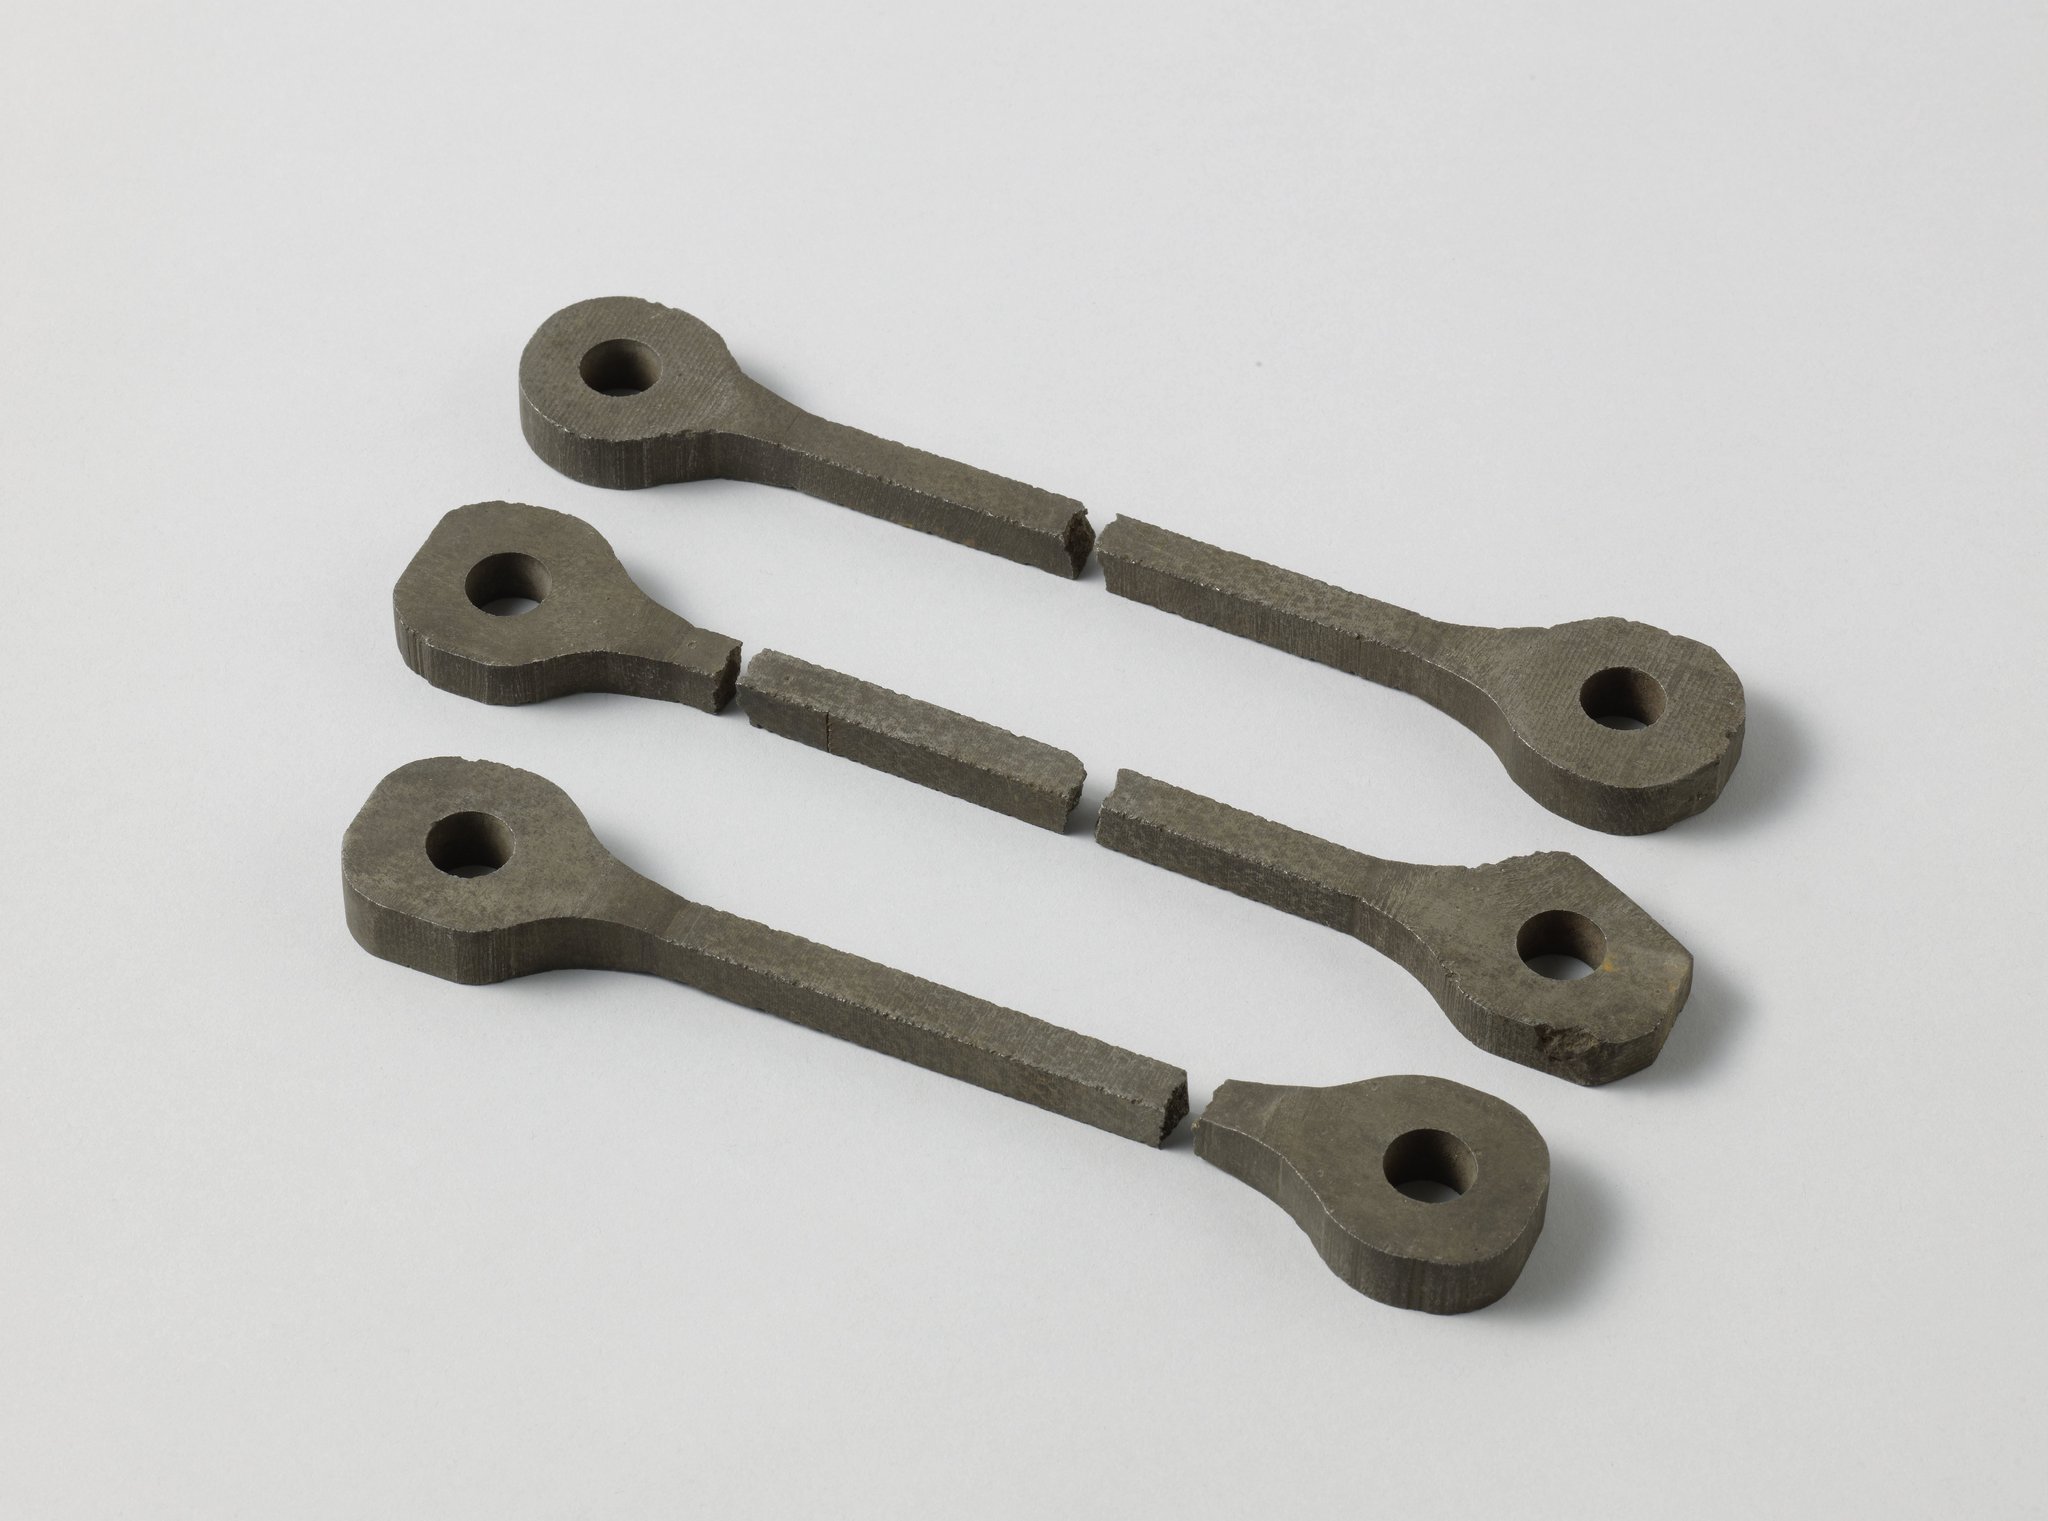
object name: sample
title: Three Cast-Iron Samples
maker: Anonymous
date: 1859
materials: iron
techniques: casting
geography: netherlands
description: Drie ijzermonsters van gietijzer, alle gebroken, één incompleet. Ze hebben alle de vorm van een kruk, dun in het midden en met wijde uiteinden met een gat erin. Eén proefstaaf is in tweeën gebroken, de tweede in drie stukken en de derde ook in drie, maar het tussenstuk daarvan ontbreekt.